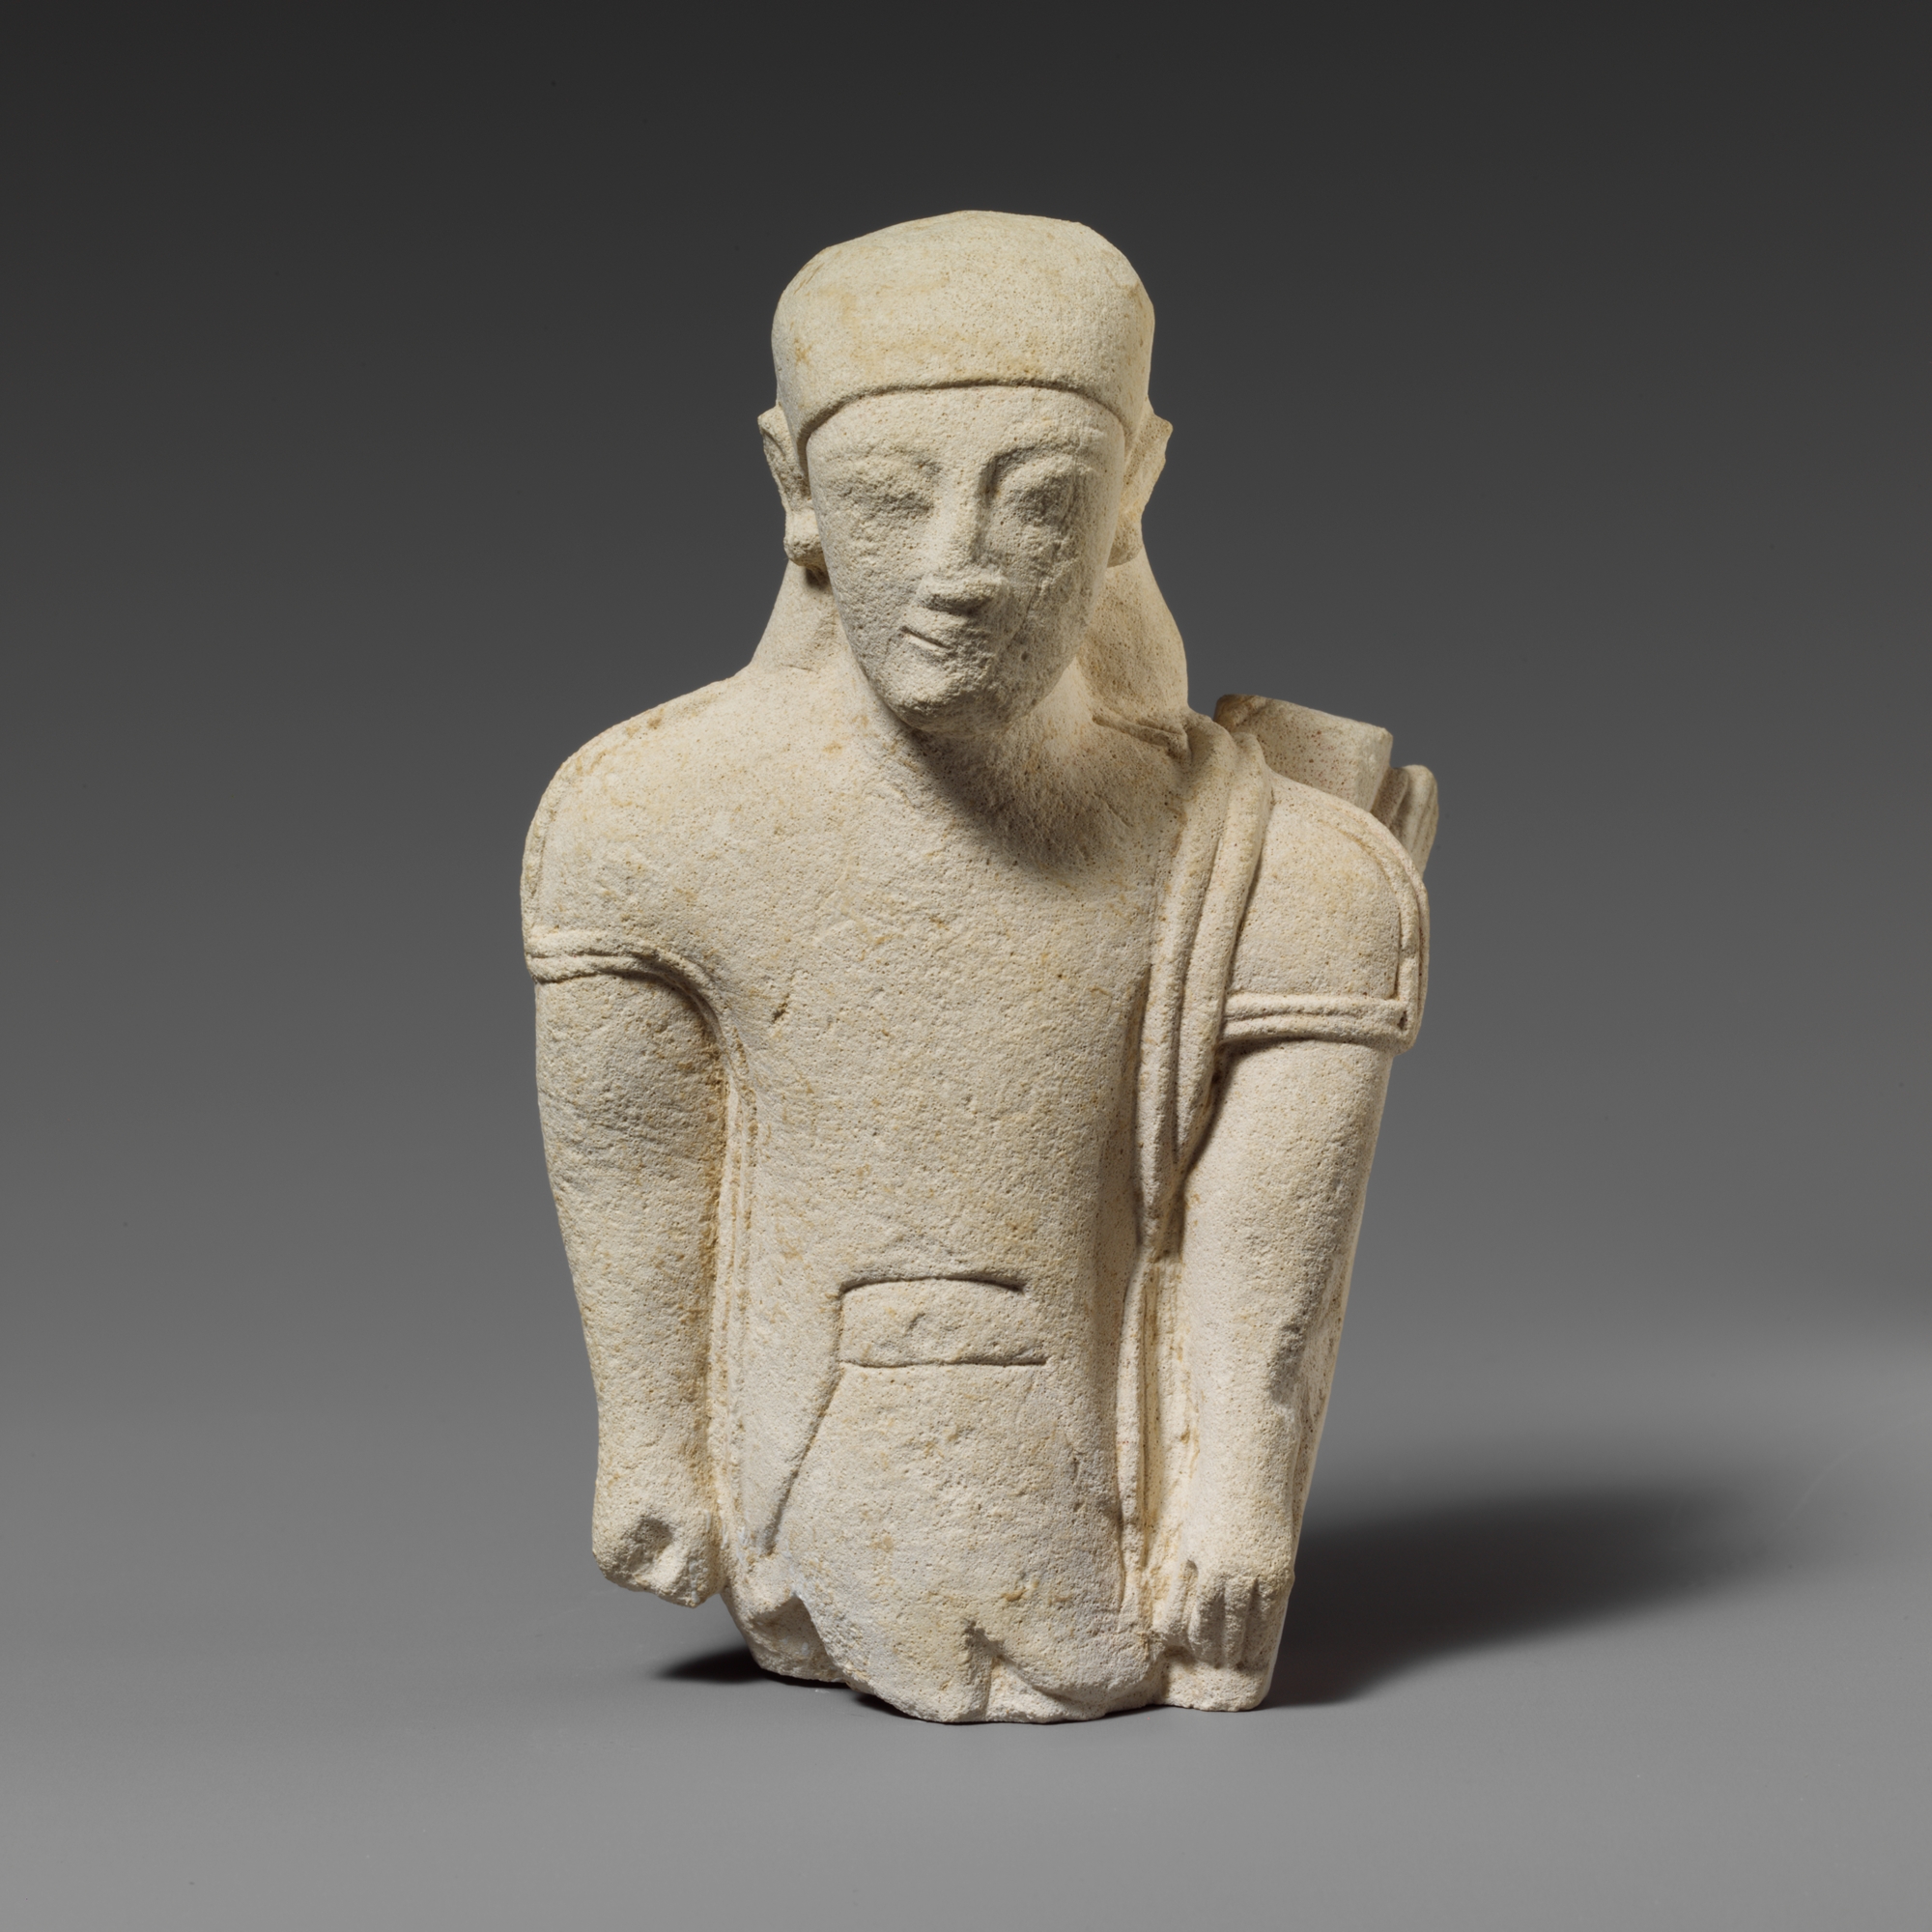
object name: statuette of an archer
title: Limestone statuette of a “hunter” in Egyptianizing dress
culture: cypriot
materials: limestone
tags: men